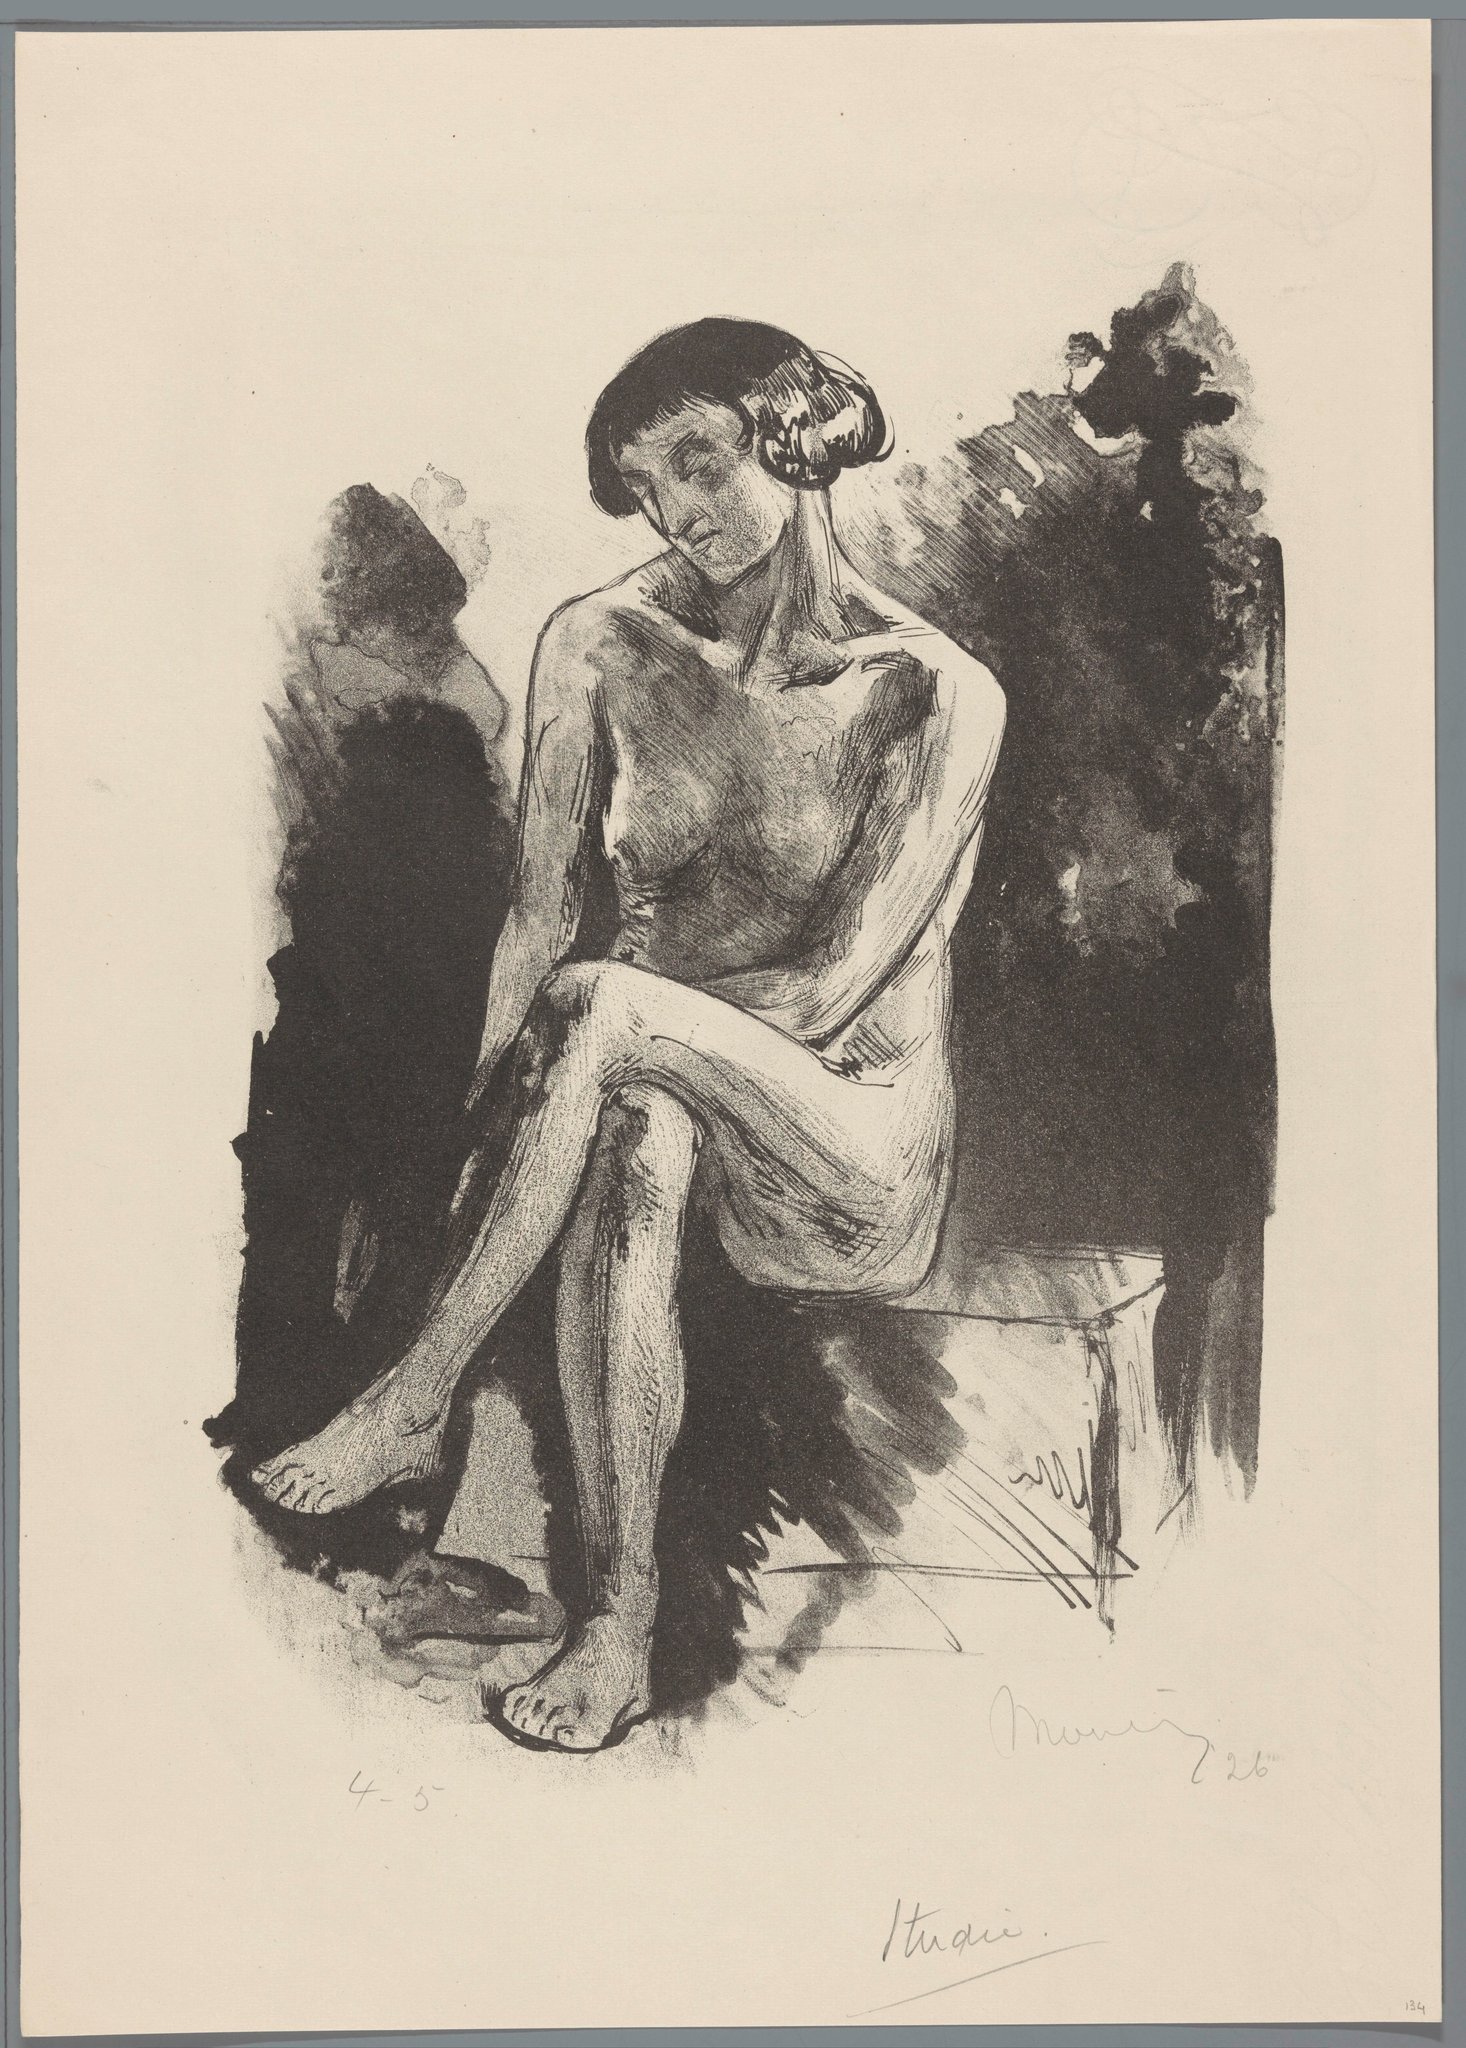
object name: print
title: Zittend naaktmodel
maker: simon moulijn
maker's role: draughtsman, print maker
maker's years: 1866-1948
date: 1926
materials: paper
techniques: lithograph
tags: sitting figure - aa - female human figure, woman (showing herself) undressed, quasi-nude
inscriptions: annotation: ‘Studie’, stamp: Lugt 2362b, collector's mark: Lugt 2228